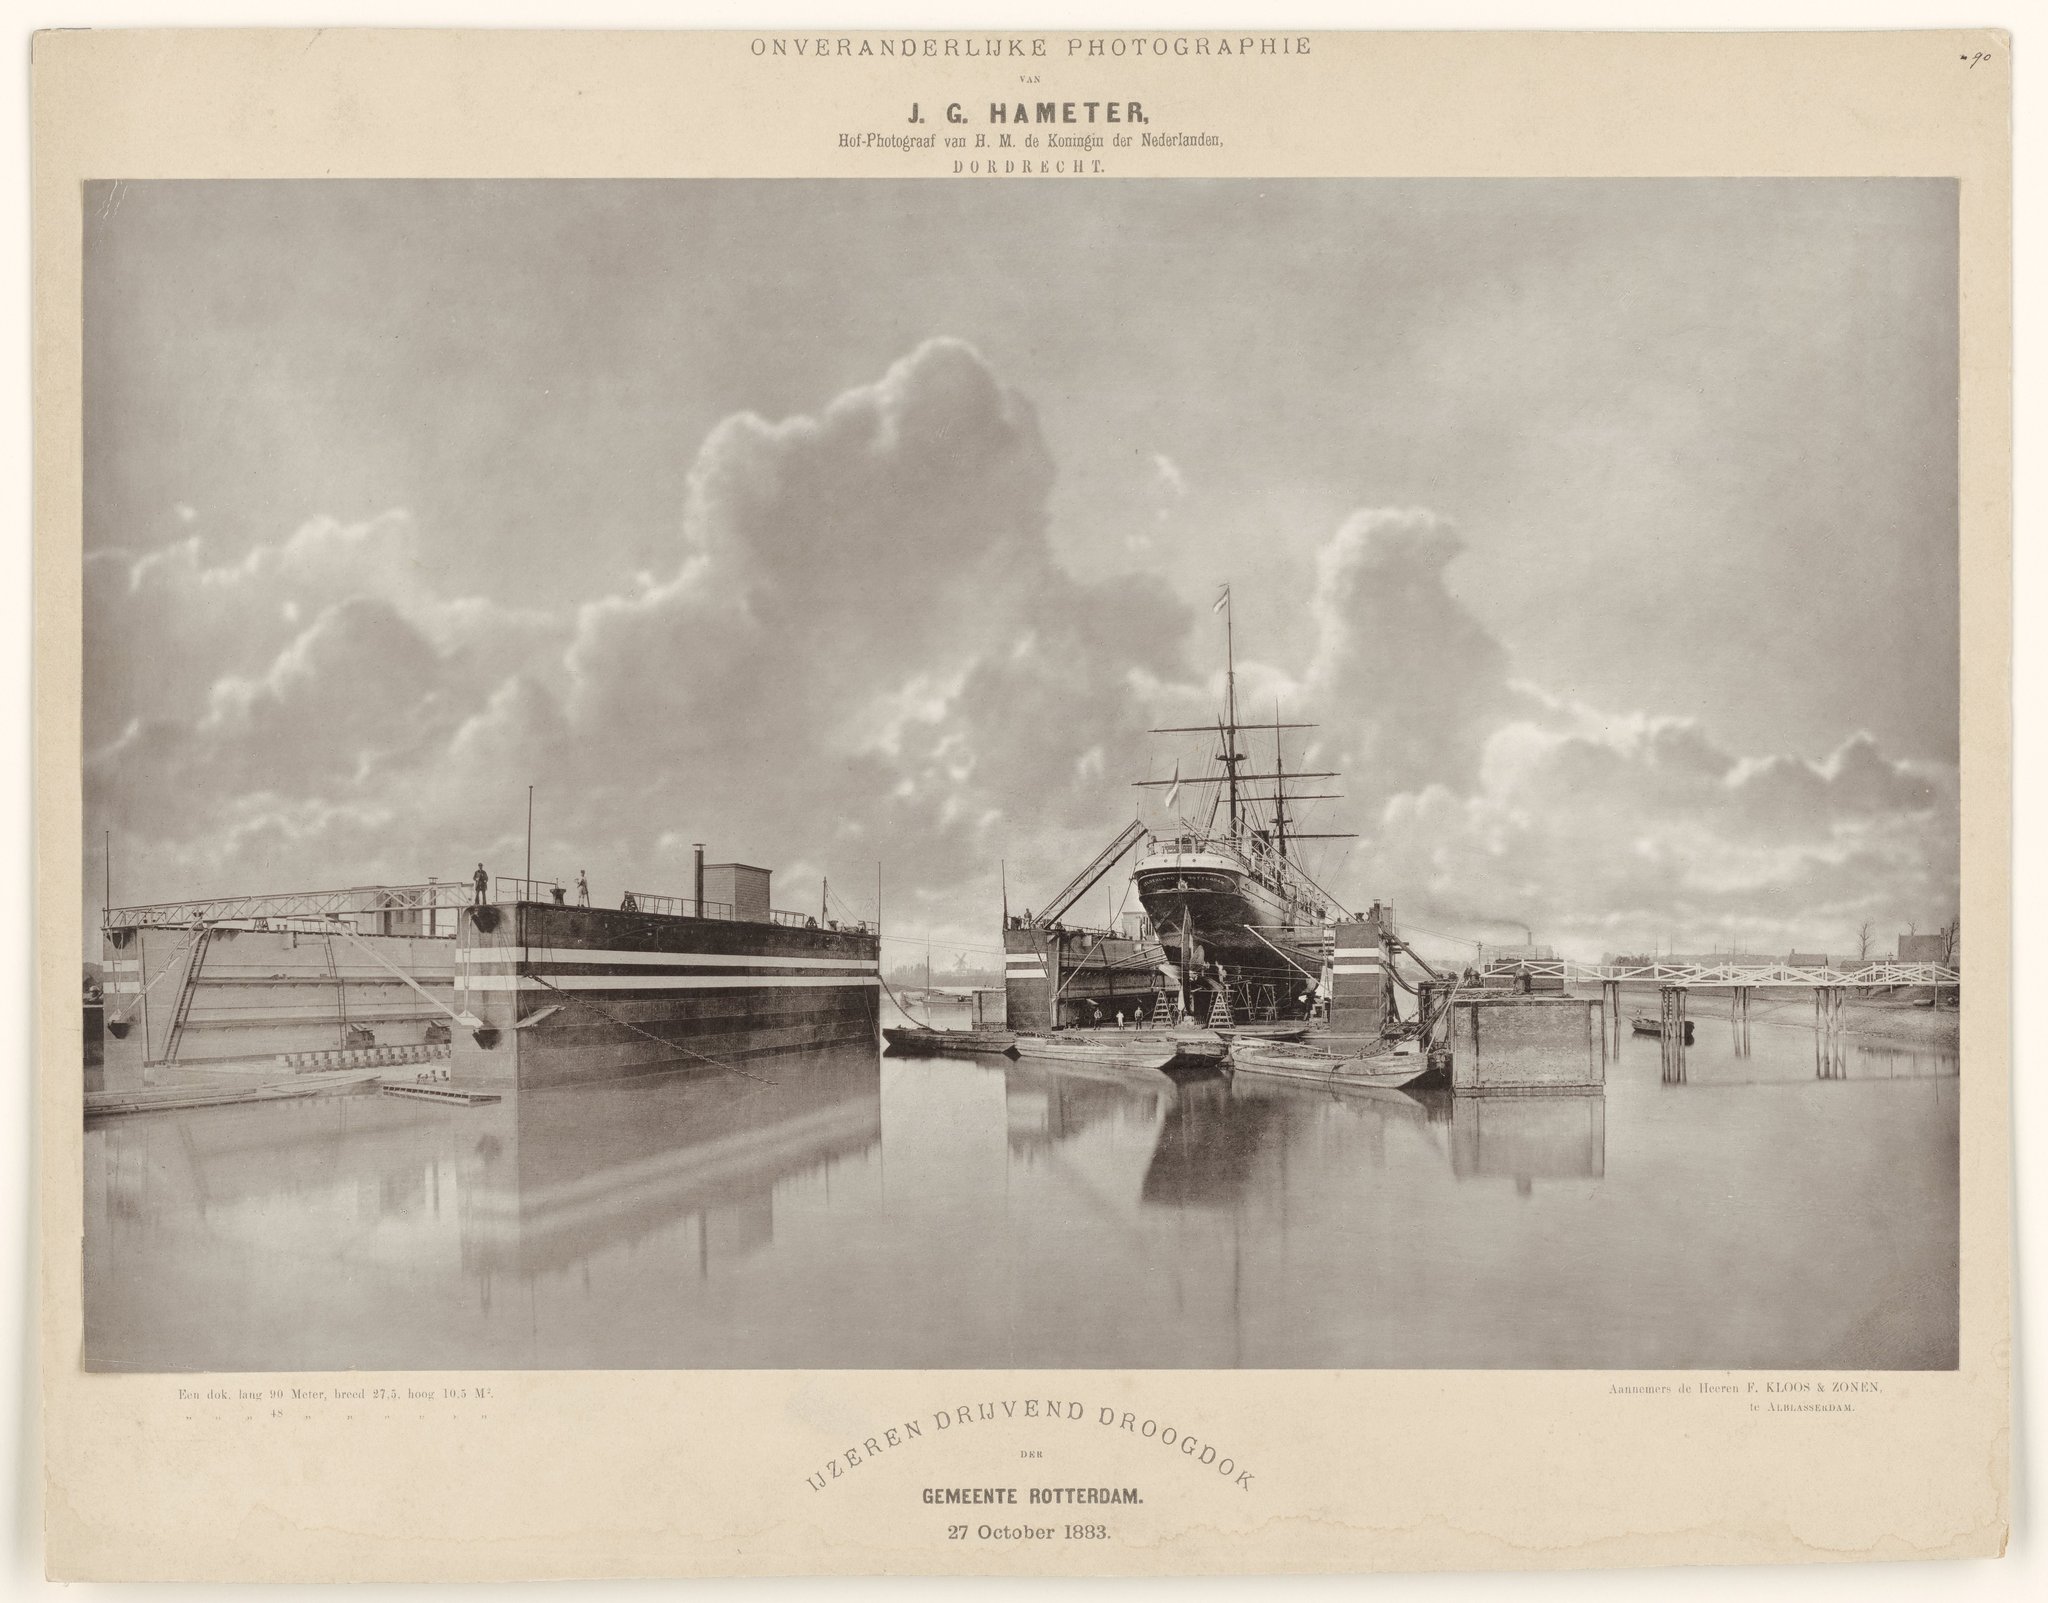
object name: photograph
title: Floating dry dock at Dokhaven in Rotterdam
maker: johann georg hameter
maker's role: fotograaf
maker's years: 1838-1885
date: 1883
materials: cardboard, paper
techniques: photograph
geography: dordrecht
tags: shipyard, shipdock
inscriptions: caption: ‘Aannemers de Heeren F. KLOOS & ZONEN te Alblasserdam’, caption: ‘Een dok, lang 60 Meter, breed 27,5, hoog 10,5 M’, inscription: ‘Onveranderlijke photographie ... Nederlanden Dordrecht’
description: In 1883, a new project was added to the ambitious plans for Rotterdam harbour: the completion of two dry docks. The structures would be 30 metres high, 90 and 45 metres long and would float on the water. That would make it easier to inspect and repair large vessels in the growing world harbour. Hameter photographed the installations from a wide panoramic angle. Later, he added a typically Dutch cloud-filled sky.